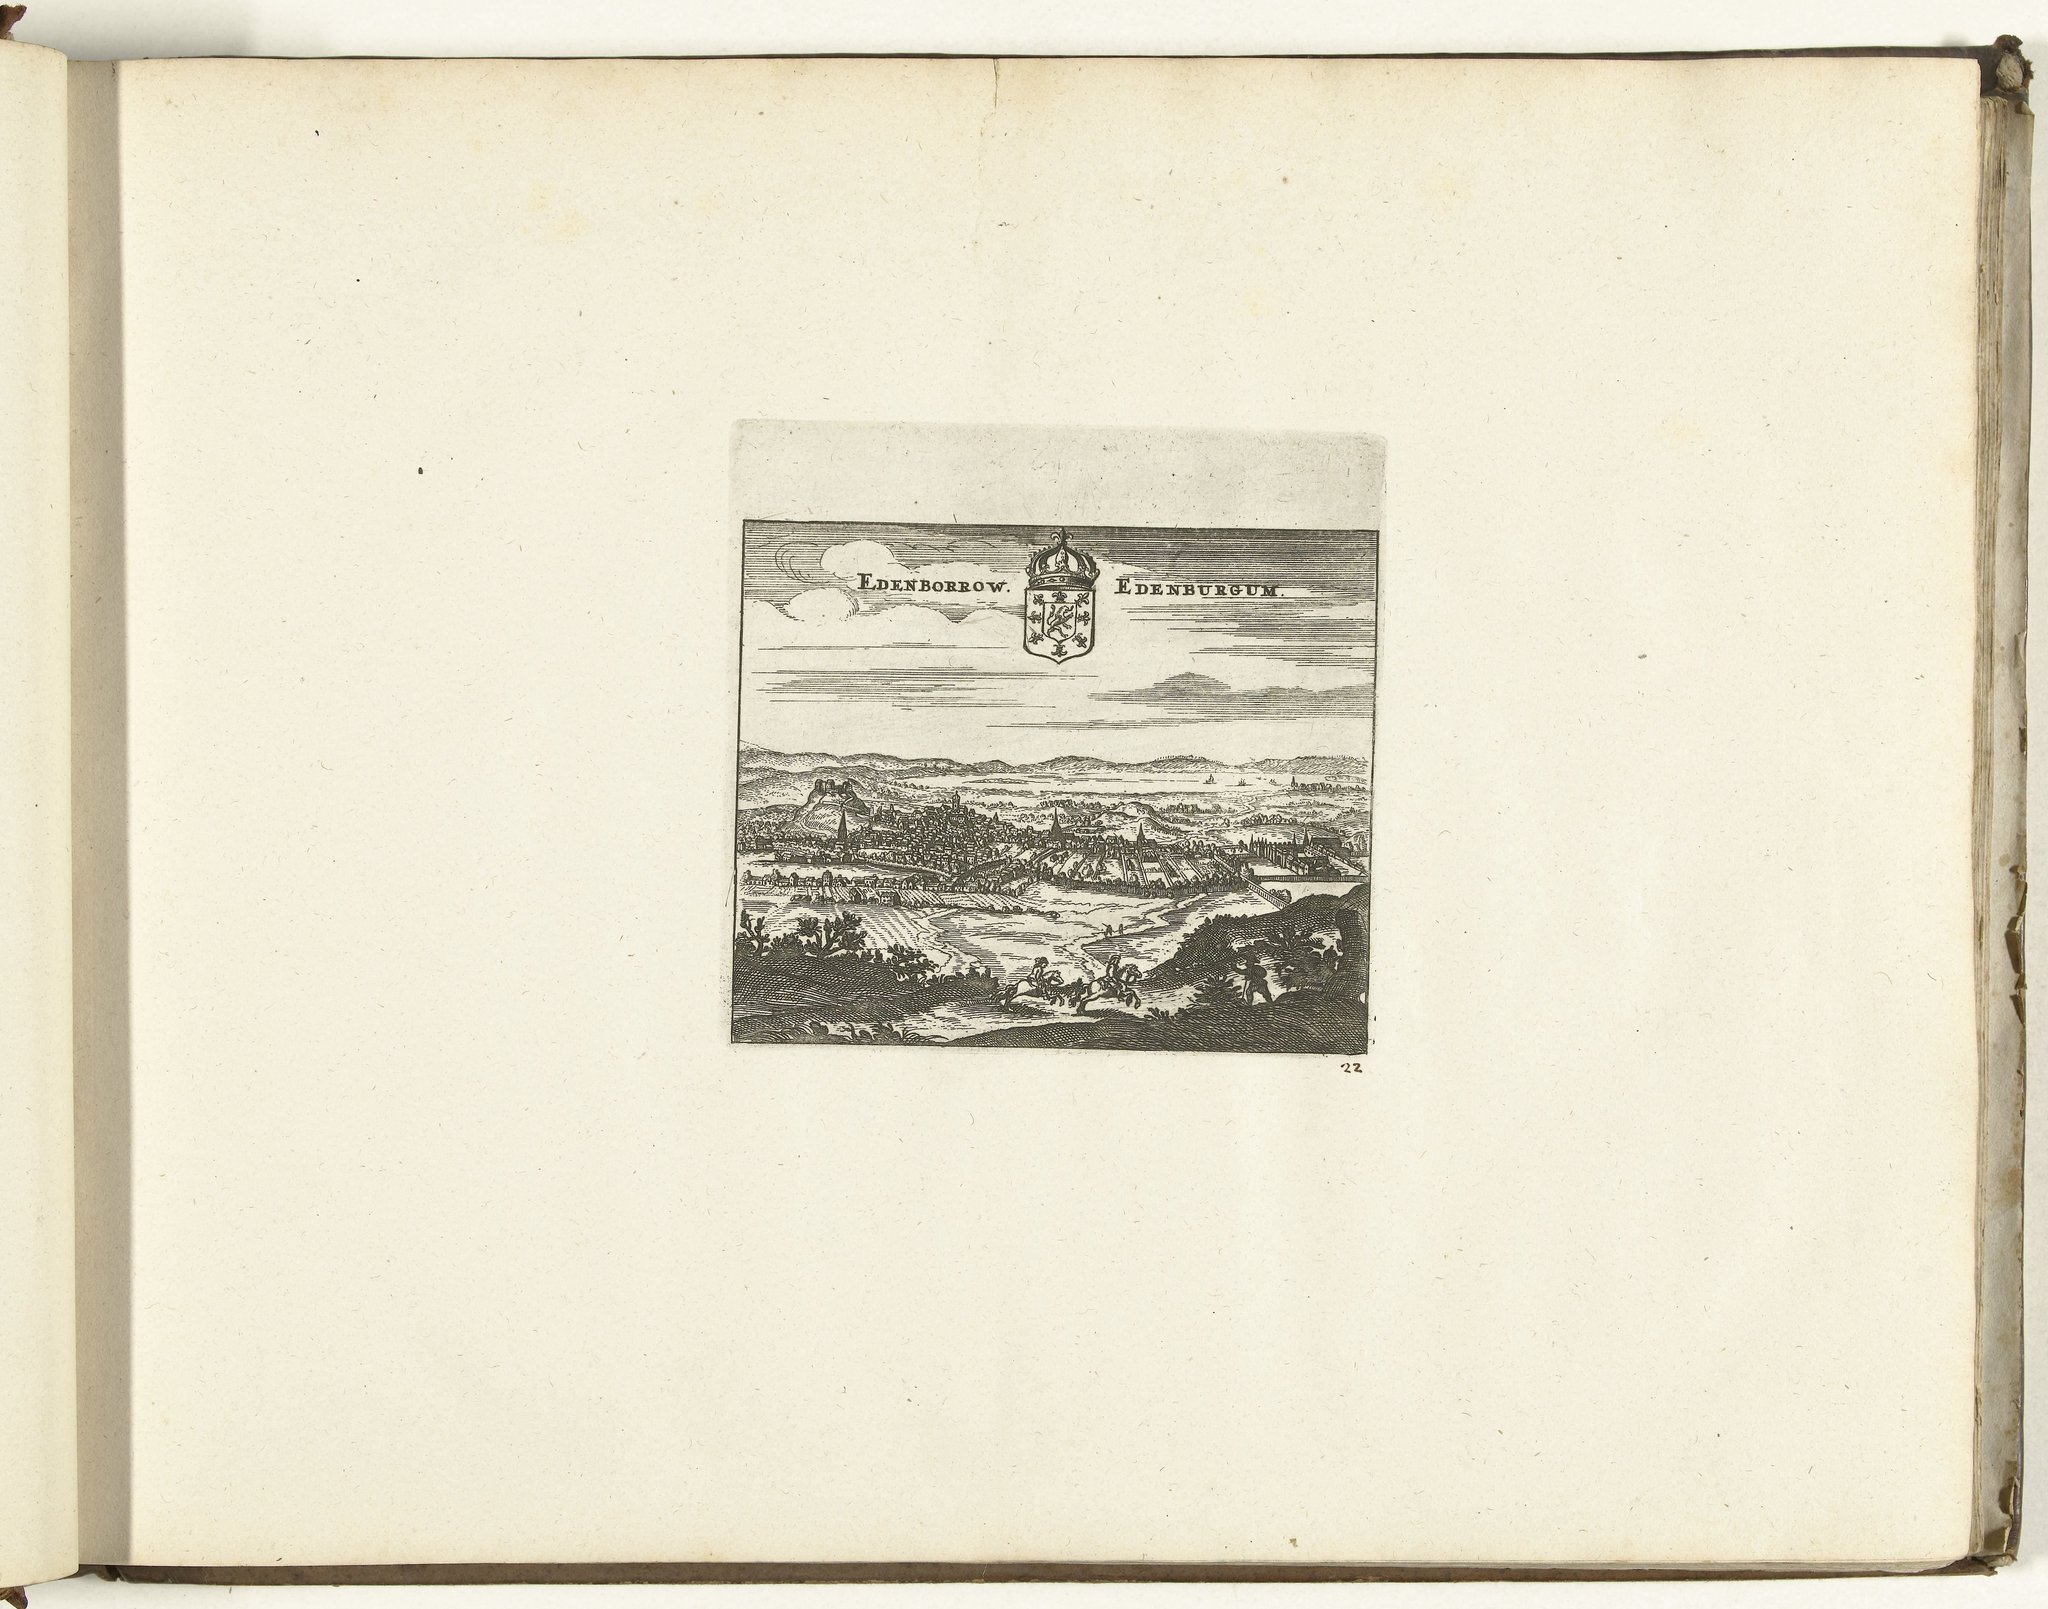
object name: print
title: Gezicht op Edinburgh, 1726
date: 1726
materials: paper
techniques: etching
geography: northern netherlands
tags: edinburgh, spaanse successieoorlog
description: Gezicht op Edinburgh. Plaat nr. 22 in deel I van het prentwerk: Les Forces de l'Europe, Asie, Afrique et Amerique ... Comme aussi les Cartes des Côtes de France et d'Espagne uit 1726, dit eerste deel met 238 met de hand genummerde platen van vermaarde sterke steden en vestingen in het kader van de Spaanse Successieoorlog 1701-1713. Voor het merendeel zijn deze platen gekopieerd naar de anonieme Franse platen van vermaarde sterke steden en vestingen: in Les forces de l'Europe en in: Le theatre de la guerre, dans les Pays-Bas, beide oorspronkelijk uitgegeven door Nicolas de Fer te Parijs (1693-1697) in het kader van de Negenjarige Oorlog. Titel in het Engels en Latijn.